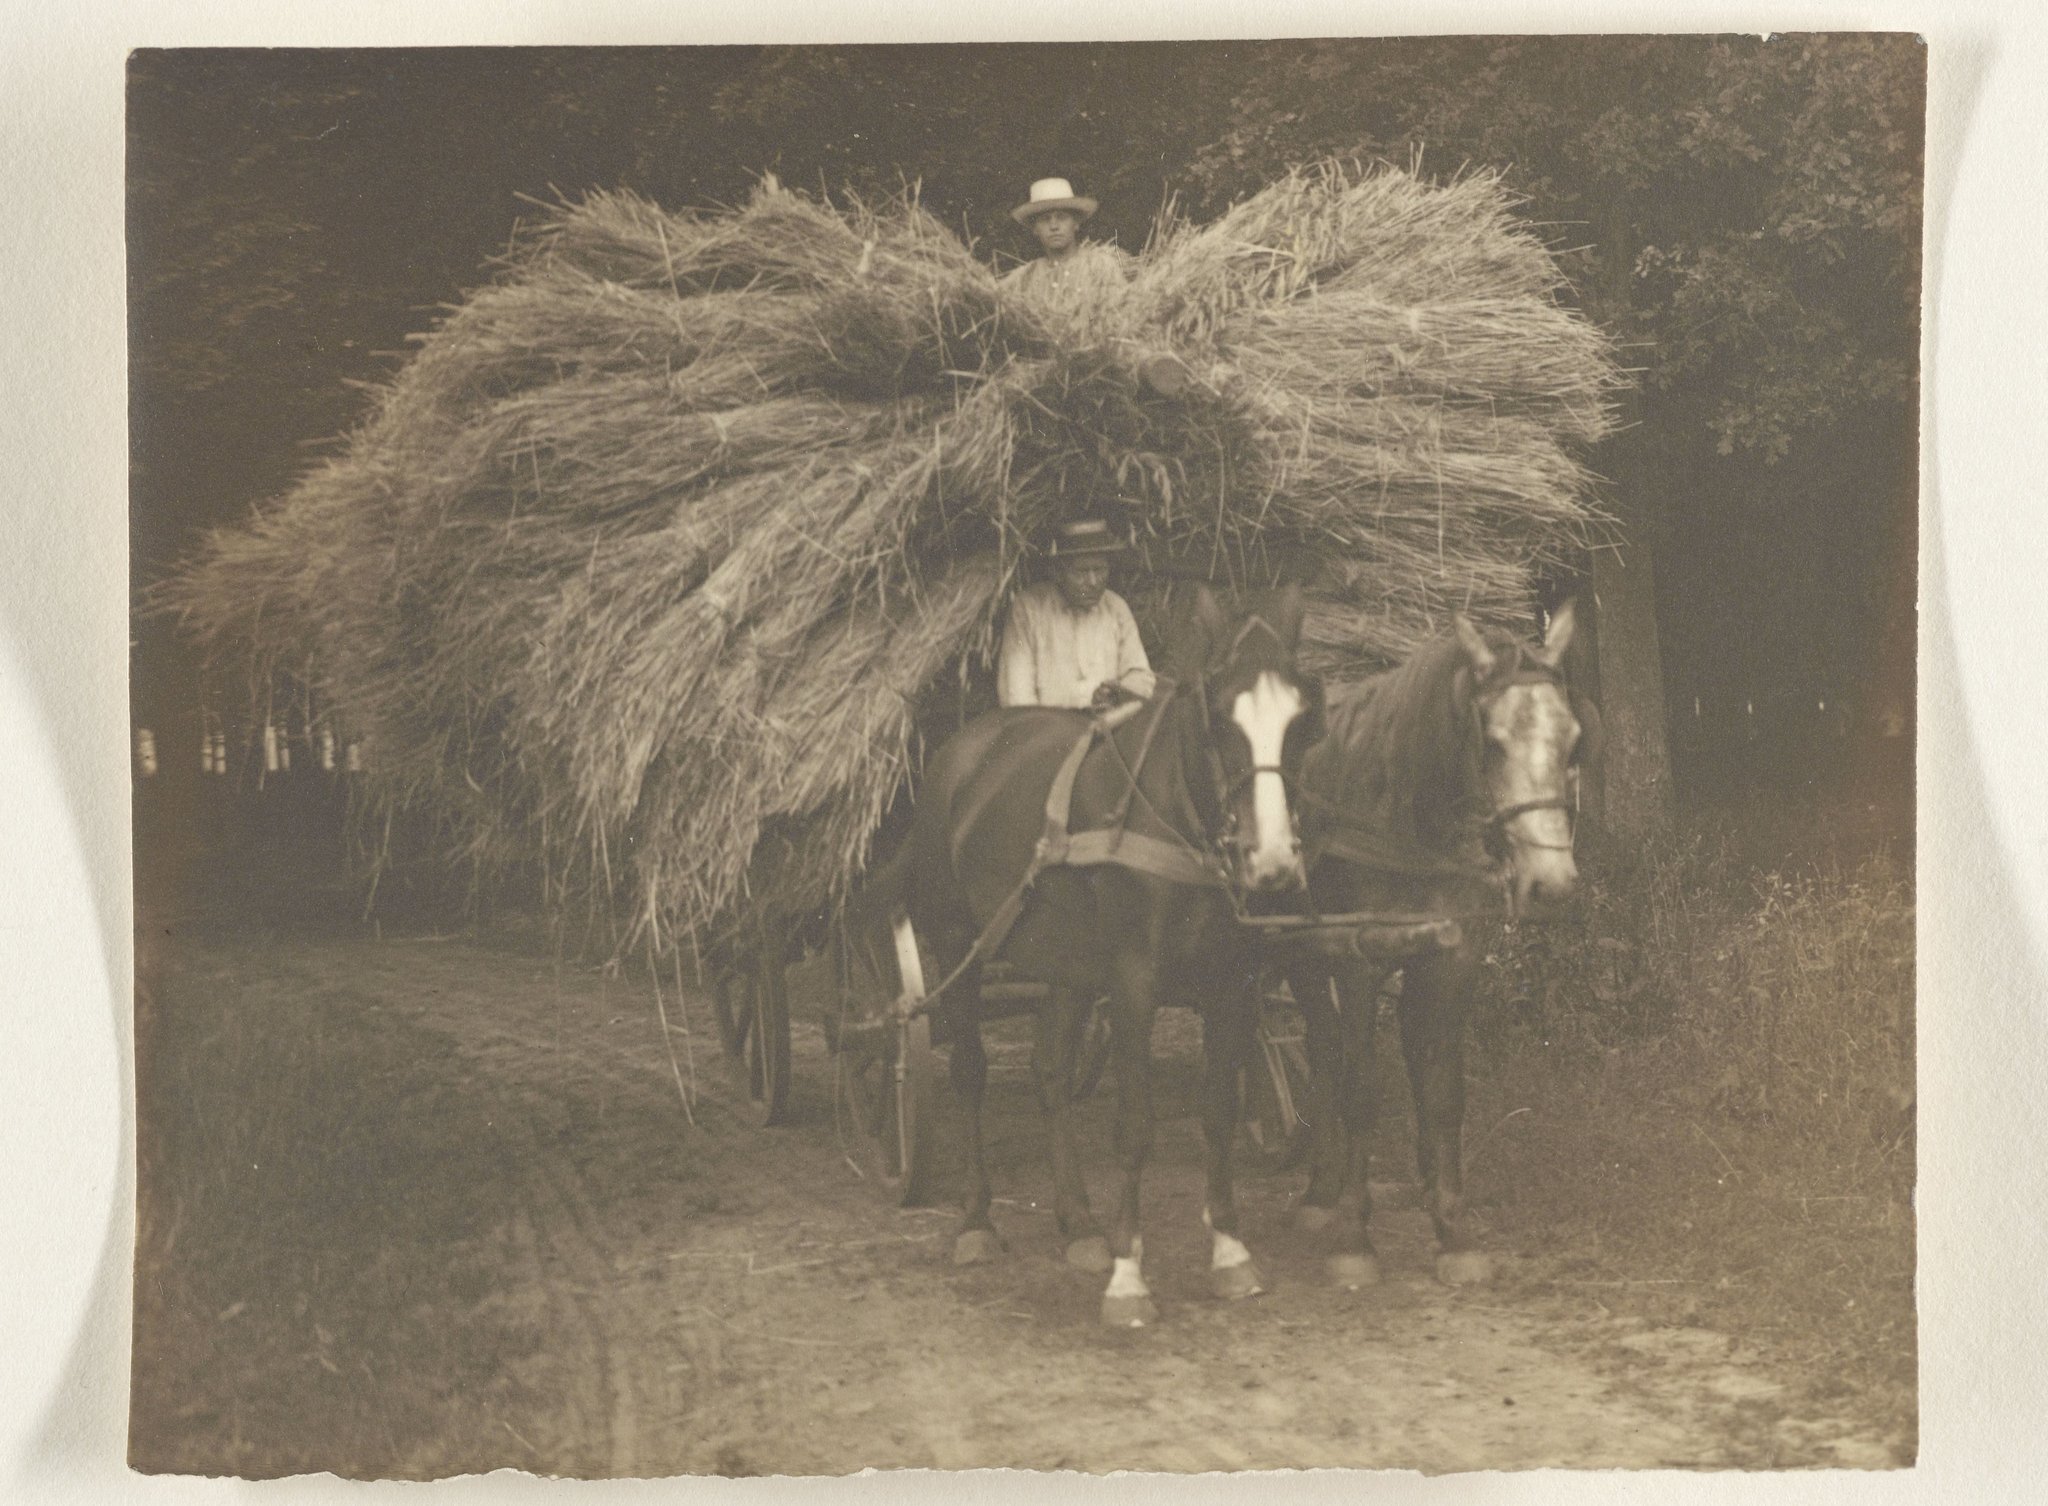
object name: photograph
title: Paard en wagen beladen met hooi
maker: richard tepe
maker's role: fotograaf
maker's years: 1864-1952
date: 1900-1930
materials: cardboard, paper, photographic support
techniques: gelatin silver print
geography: netherlands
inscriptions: stamp: ‘chamois Normal’